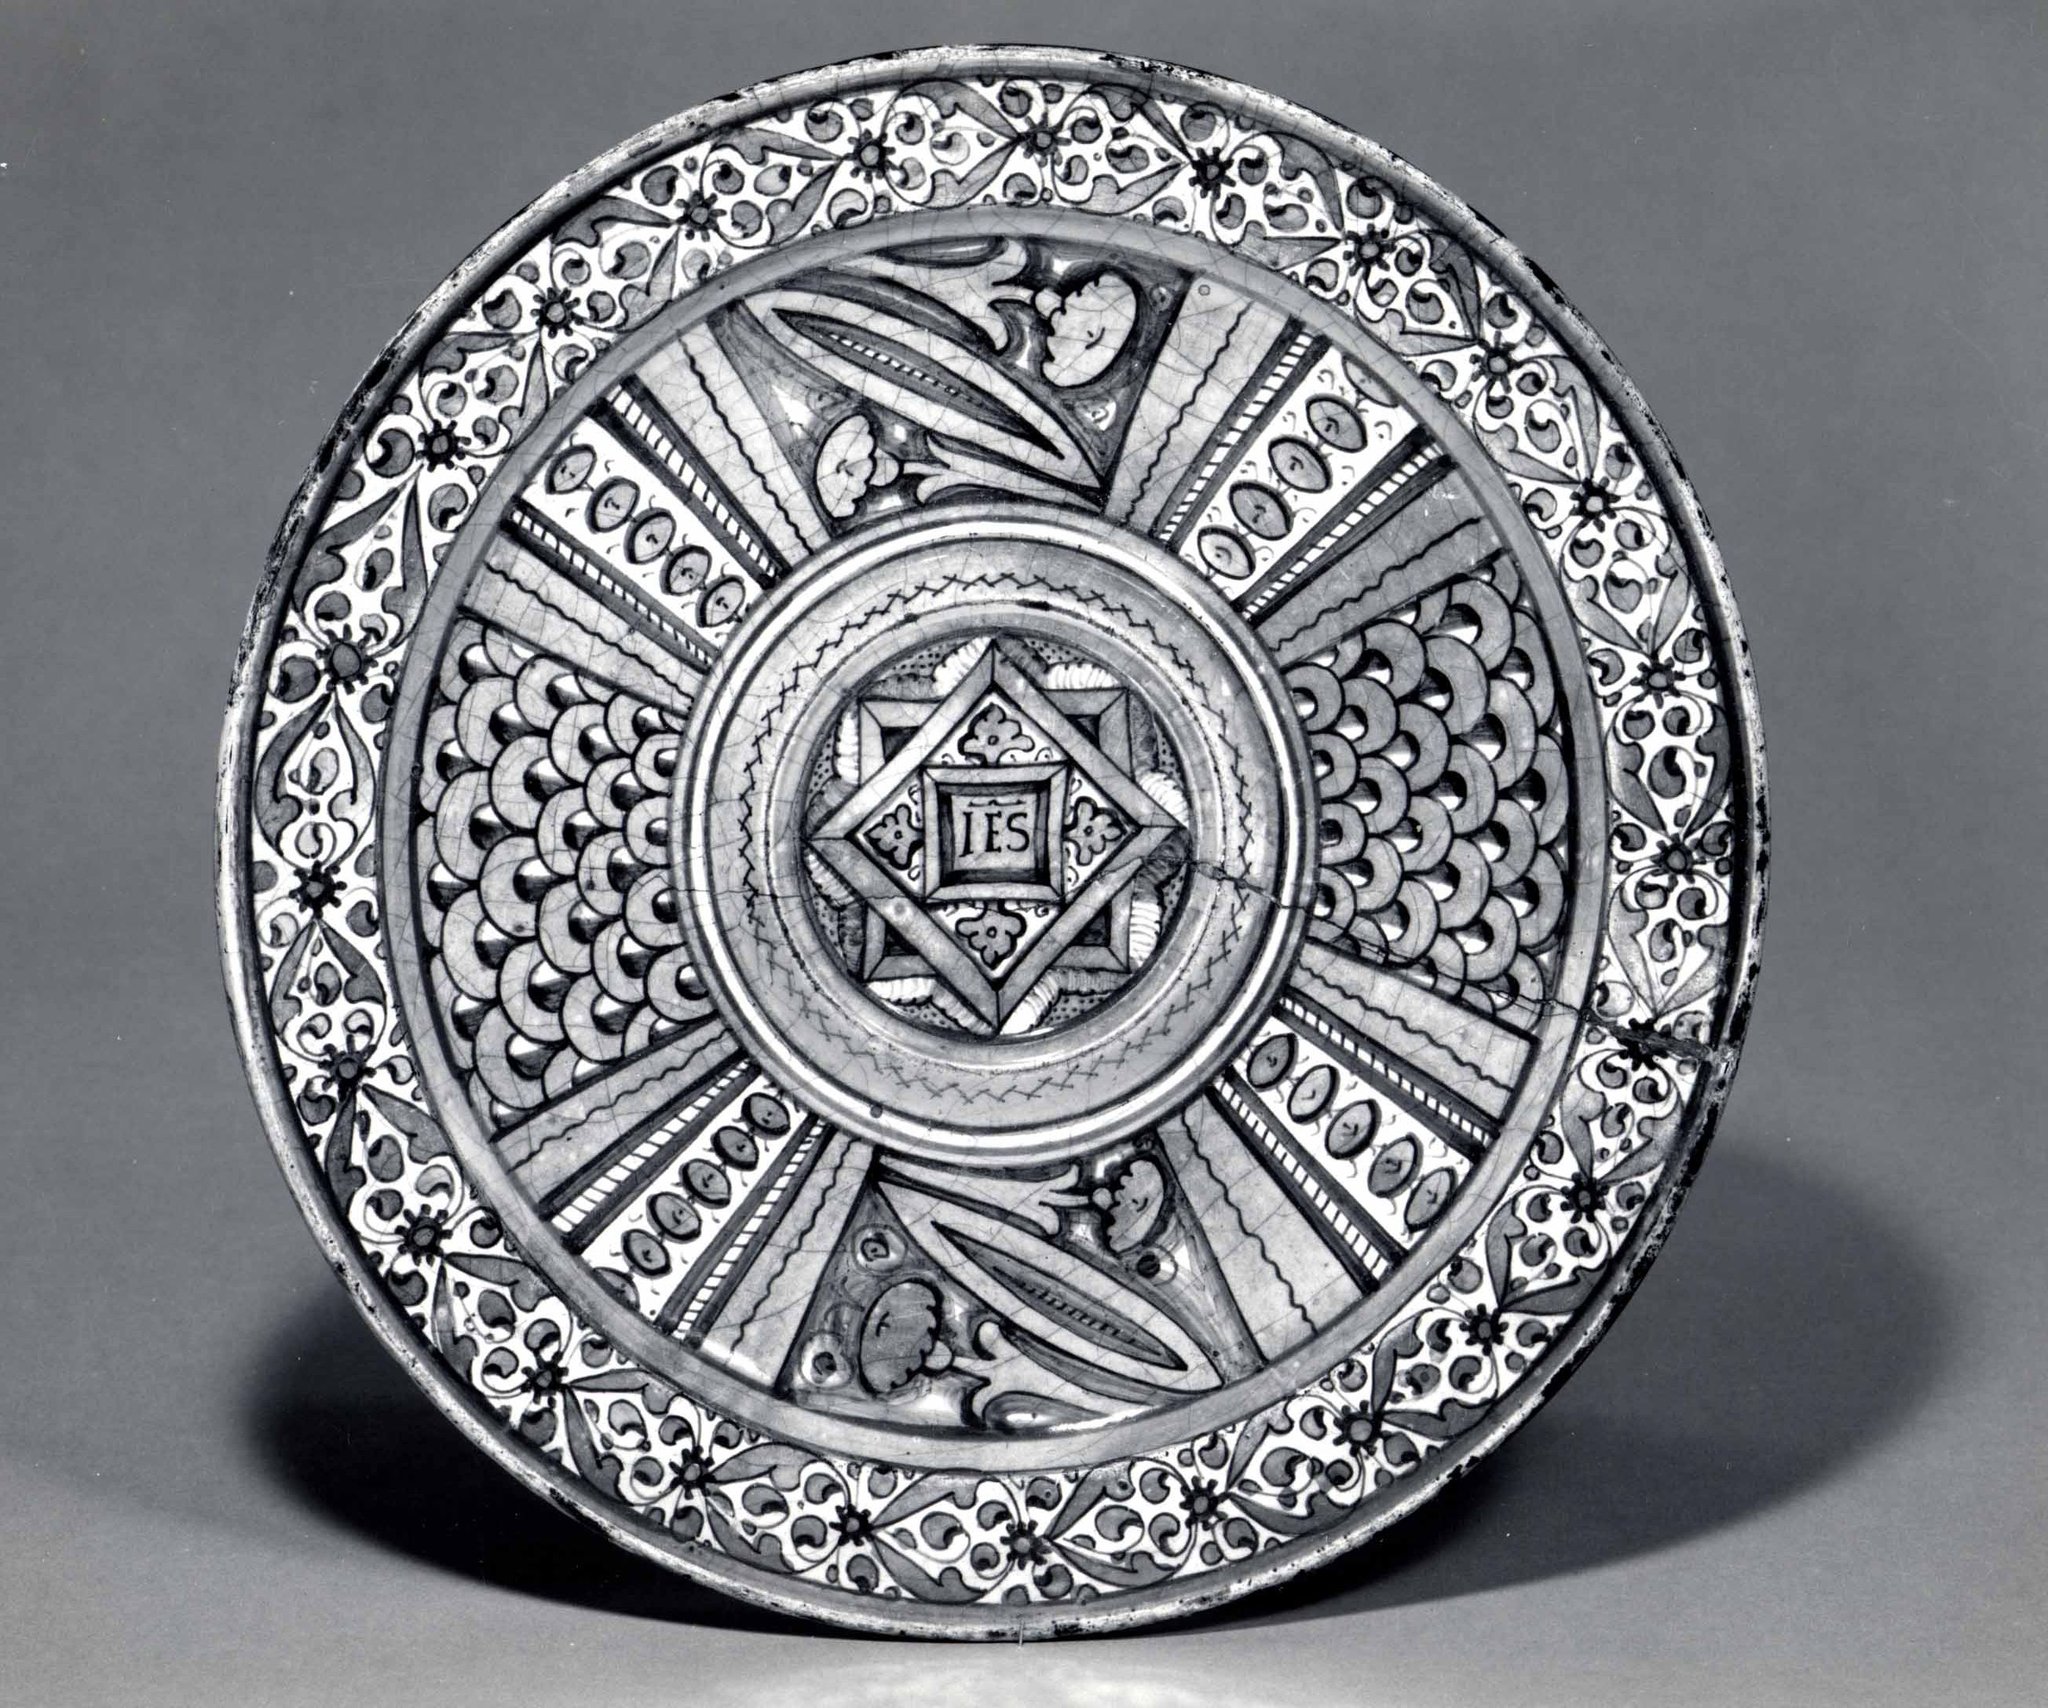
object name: ewer dish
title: Dish for a ewer (bacile da versatore)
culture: italian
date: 1530-1540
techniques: maiolica, glazing